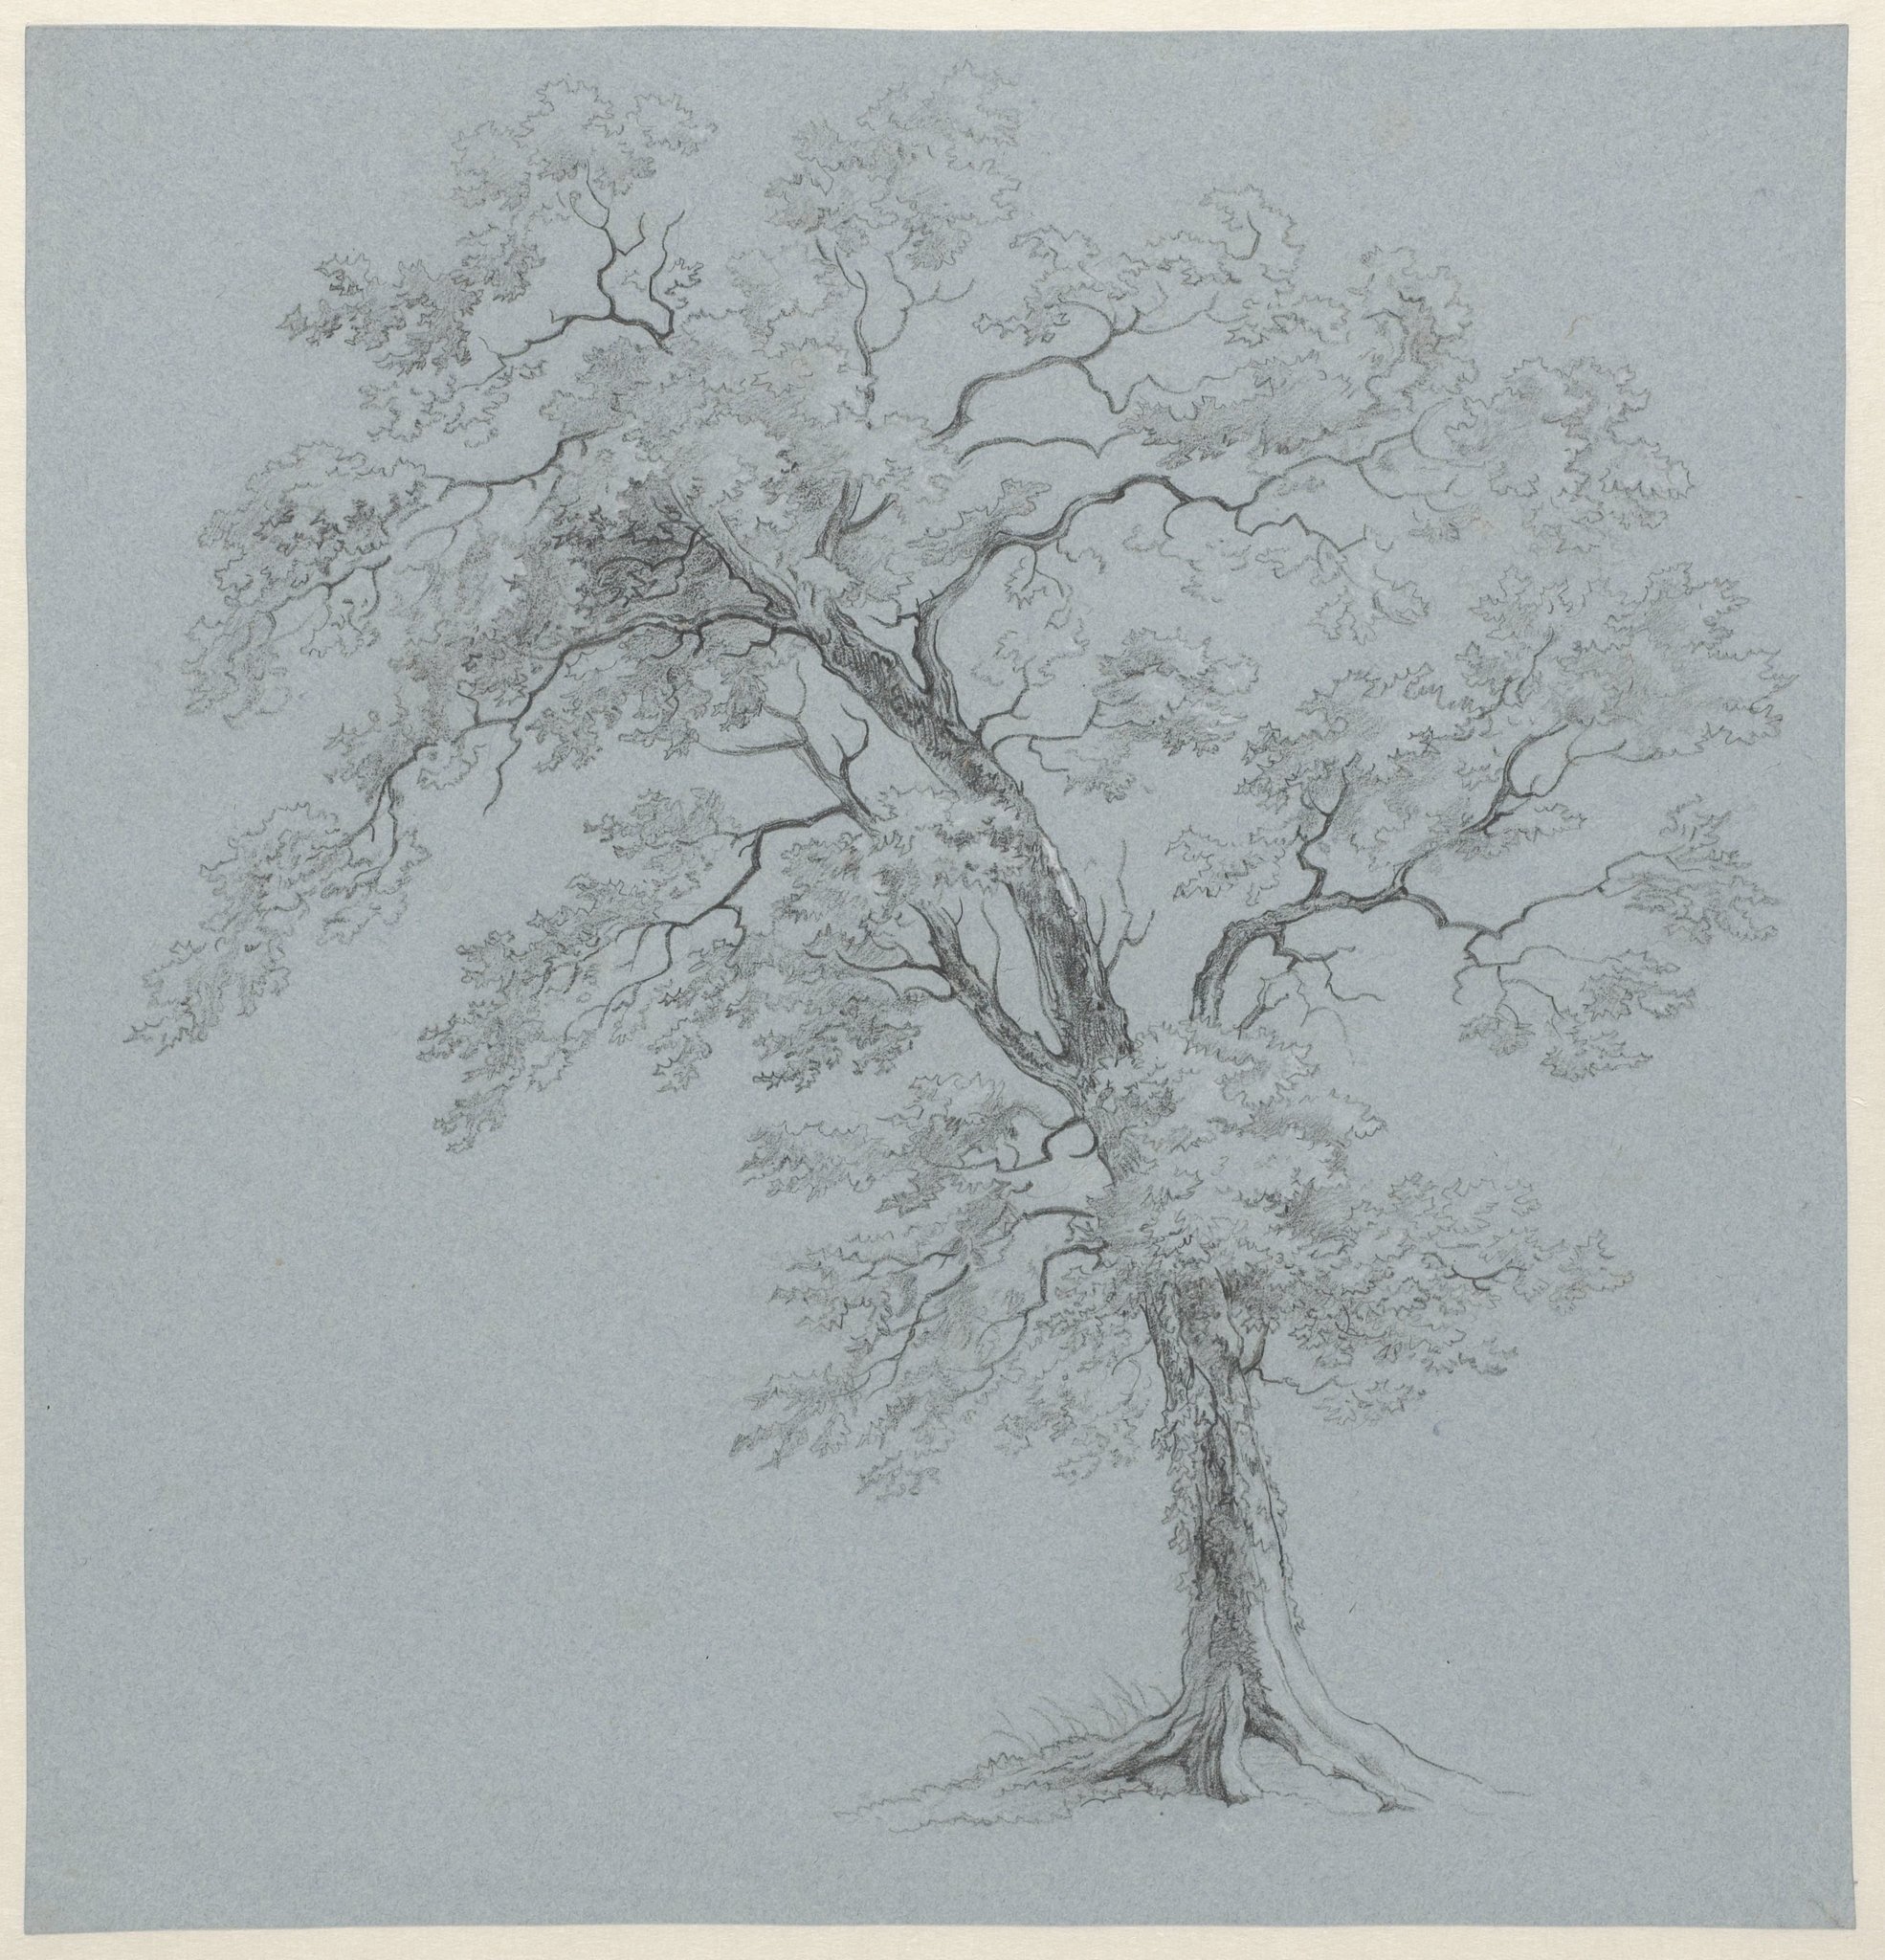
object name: drawing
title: Boomstudie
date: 1786-1857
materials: chalk, paper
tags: trees, italy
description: Tekening uit een groep tekeningen van landschappen en stadsgezichten in Italië (Rome, Tivoli, Civita Castellana en Pozzuoli).